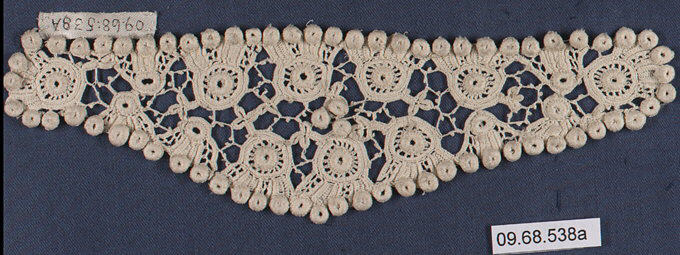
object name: collar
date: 1801-1900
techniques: crochet